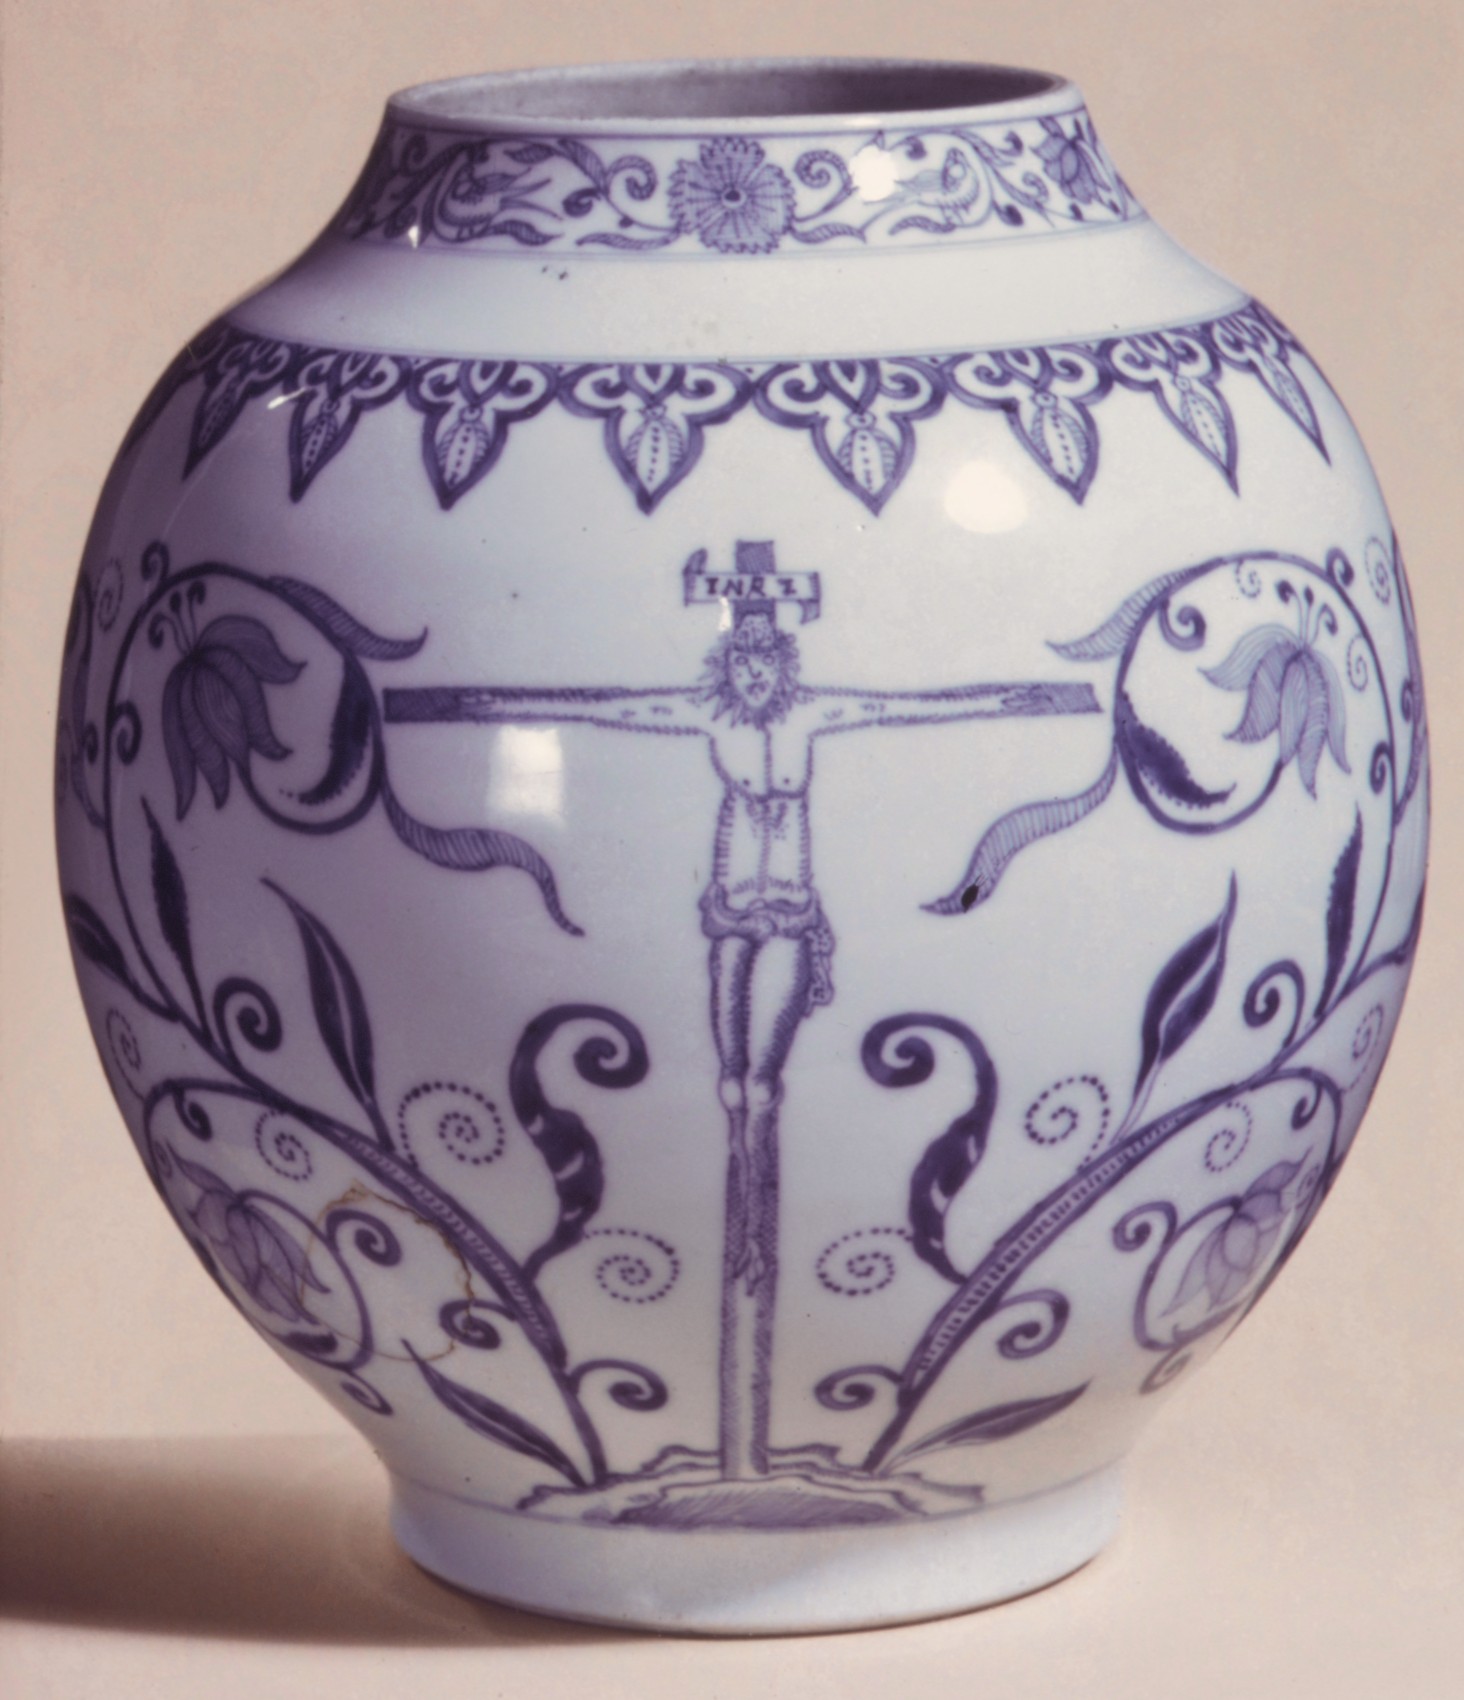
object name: jar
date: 1690-1700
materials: hard paste porcelain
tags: flowers,crucifixion